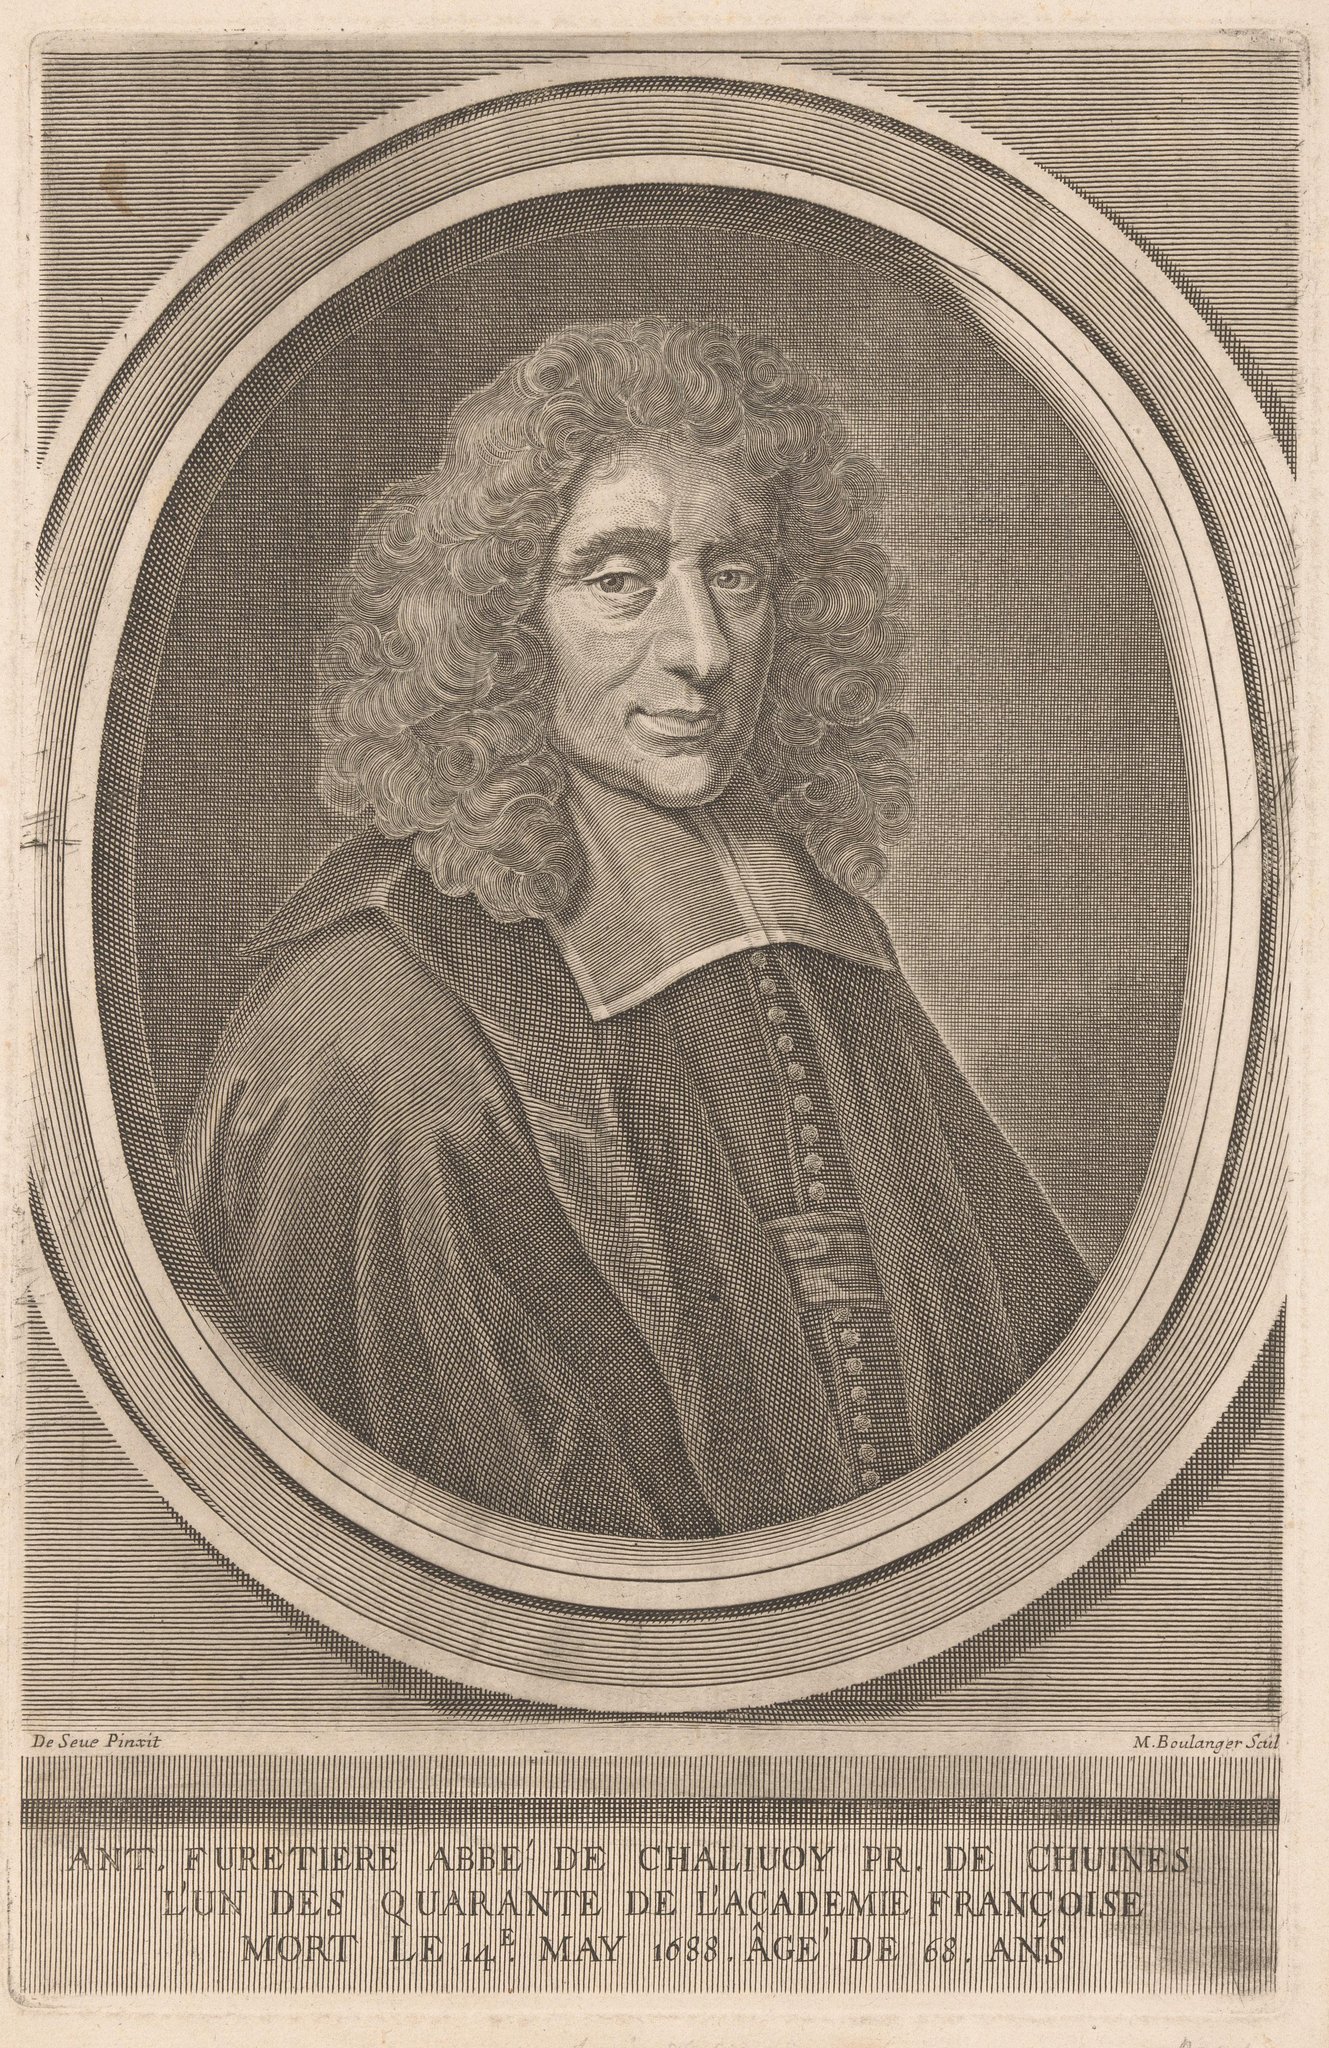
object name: print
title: Portret van Antoine Furetière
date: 1688-1699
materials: paper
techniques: engraving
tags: paris, scholar, philosopher, historical persons, portrait of a writer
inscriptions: collector's mark: Lugt 2228